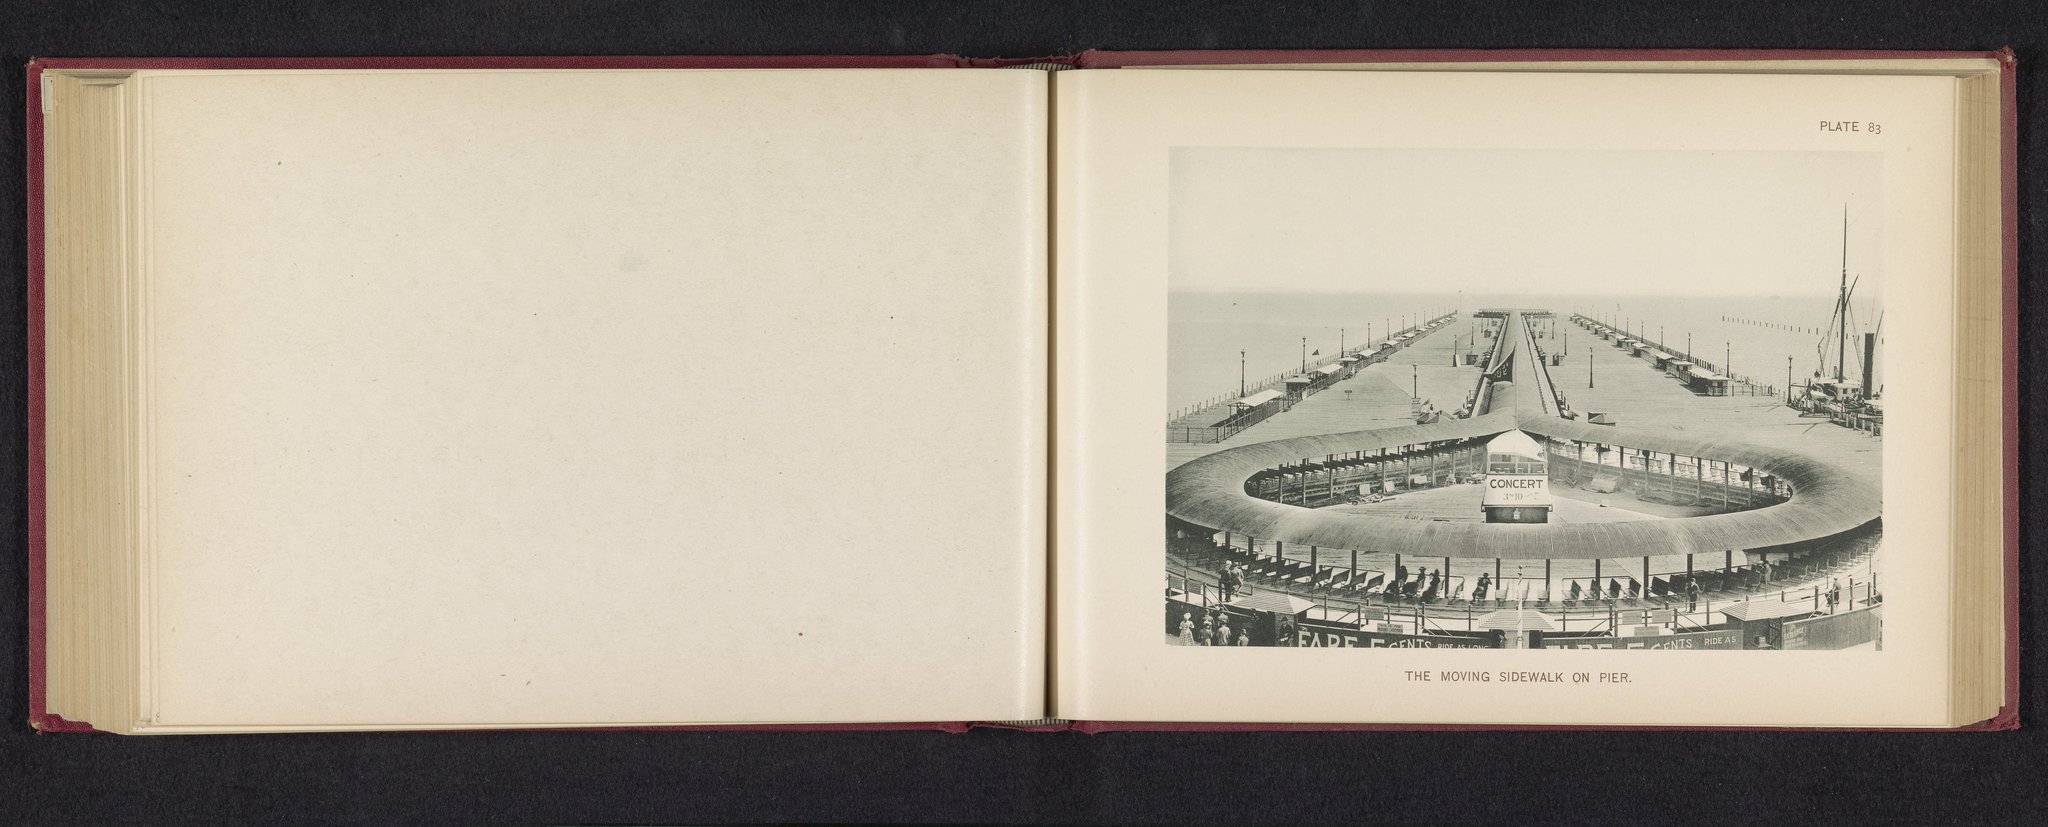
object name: photomechanical print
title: Gezicht op een pier in het Michiganmeer met een bewegend platform voor de World's Columbian Exposition in Chicago in 1893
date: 1893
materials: paper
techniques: photograph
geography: chicago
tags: world fair, world exhibition, pier, quay, wharf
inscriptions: number: ‘Plate 83’